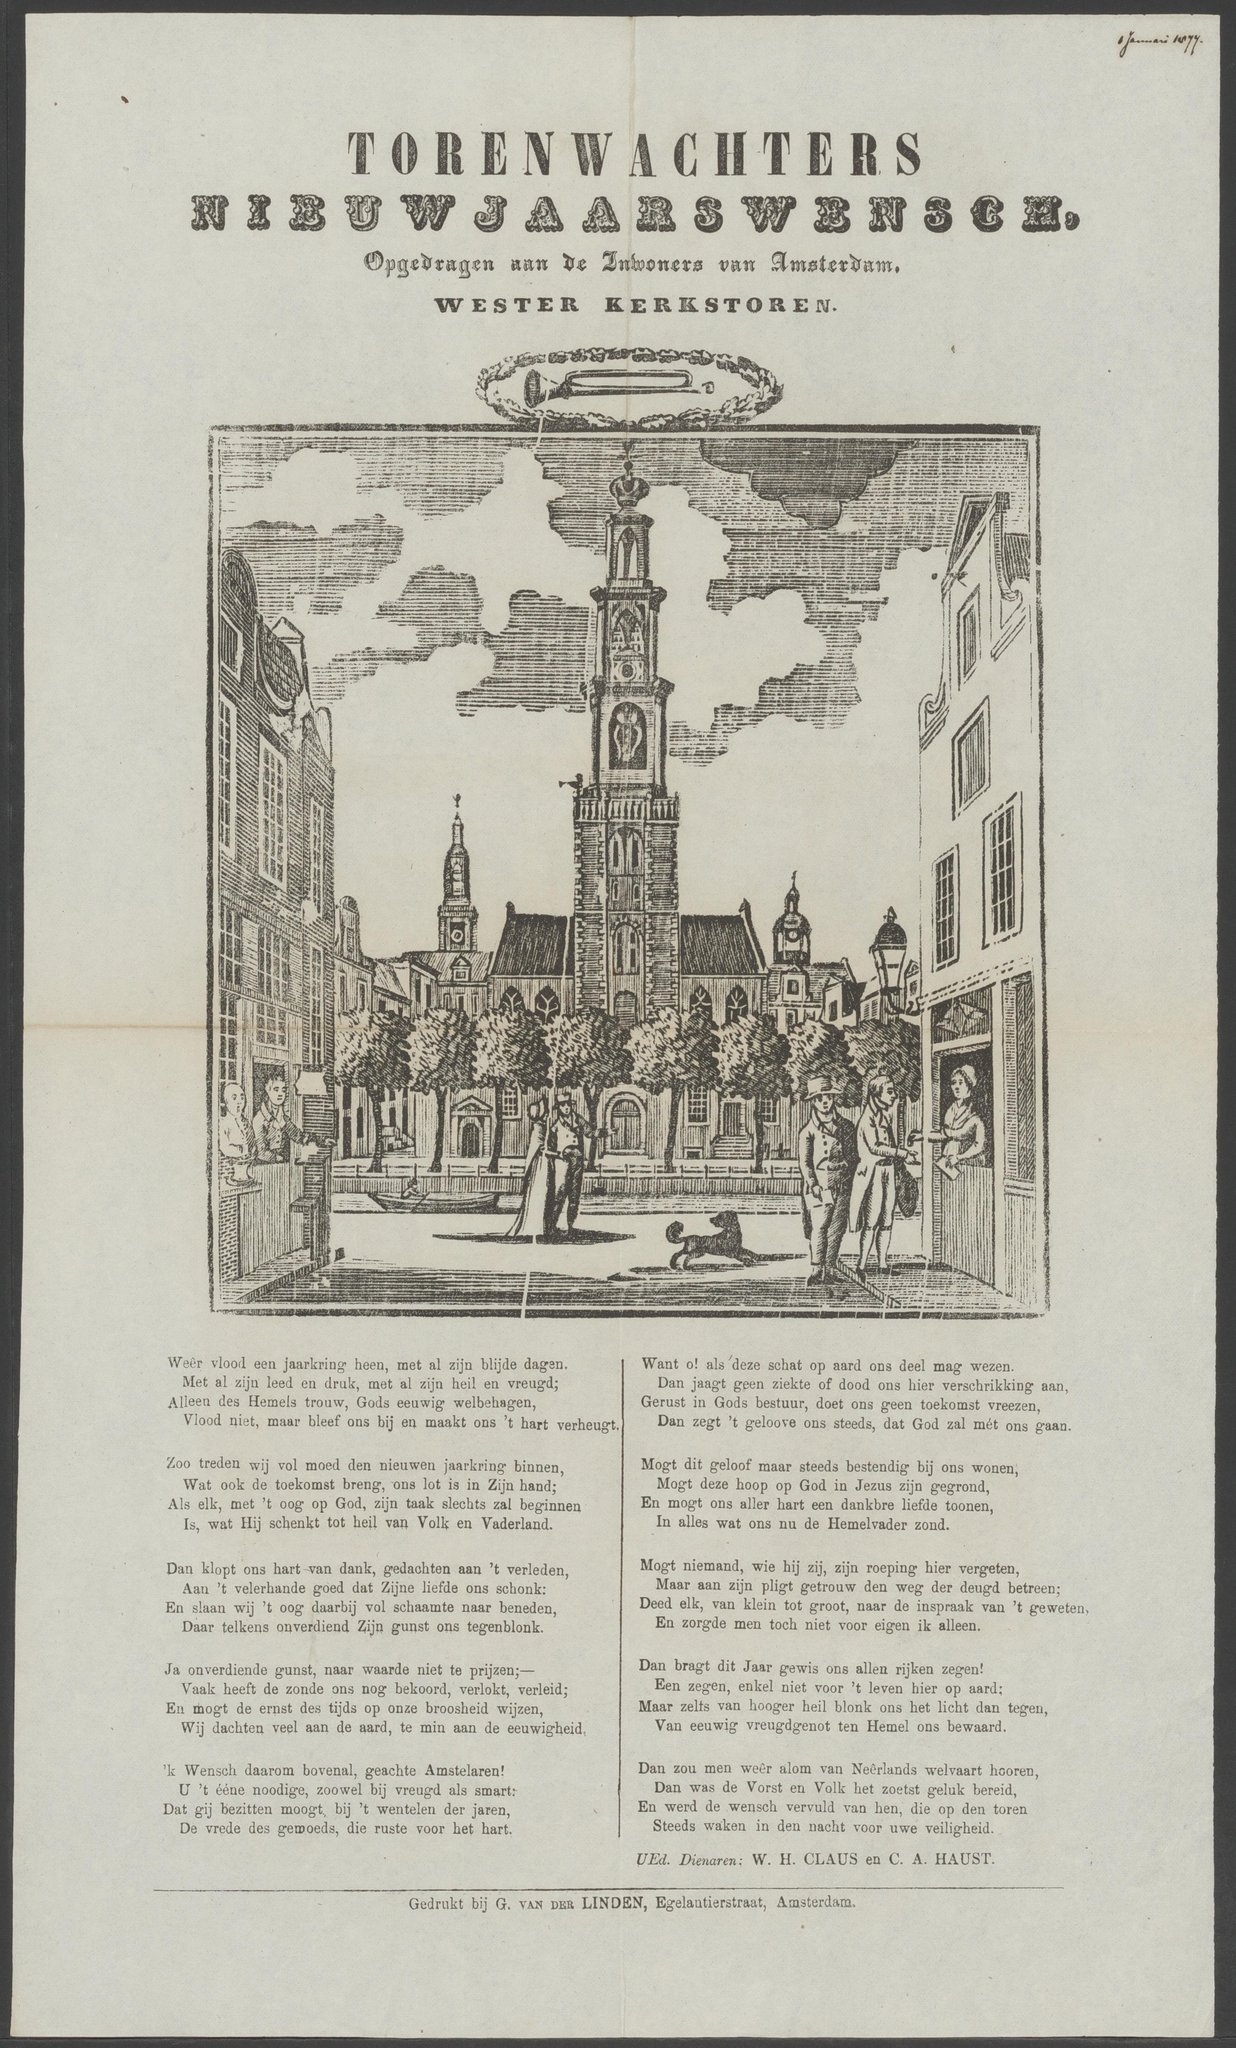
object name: print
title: Nieuwjaarswens van de torenwachters van de Westerkerkstoren te Amsterdam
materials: paper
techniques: letterpress printing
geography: amsterdam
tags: parts of church exterior and annexes: tower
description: Nieuwjaarswens van de torenwachters van de Westerkerkstoren te Amsterdam. Bovenaan een gezicht op een kerktoren. Daaronder centraal een gedicht in twee kolommen. Aangeboden door de torenwachters: W.H. Claus en C.H. Haust. Onderwerpsrubrieken binnen de Atlas Zeden en Gewoonten: Zeden en gewoonten in engeren zin, Volksleven, Volksbladen, Nieuwjaars- en Kerstwenschen, Amsterdam.